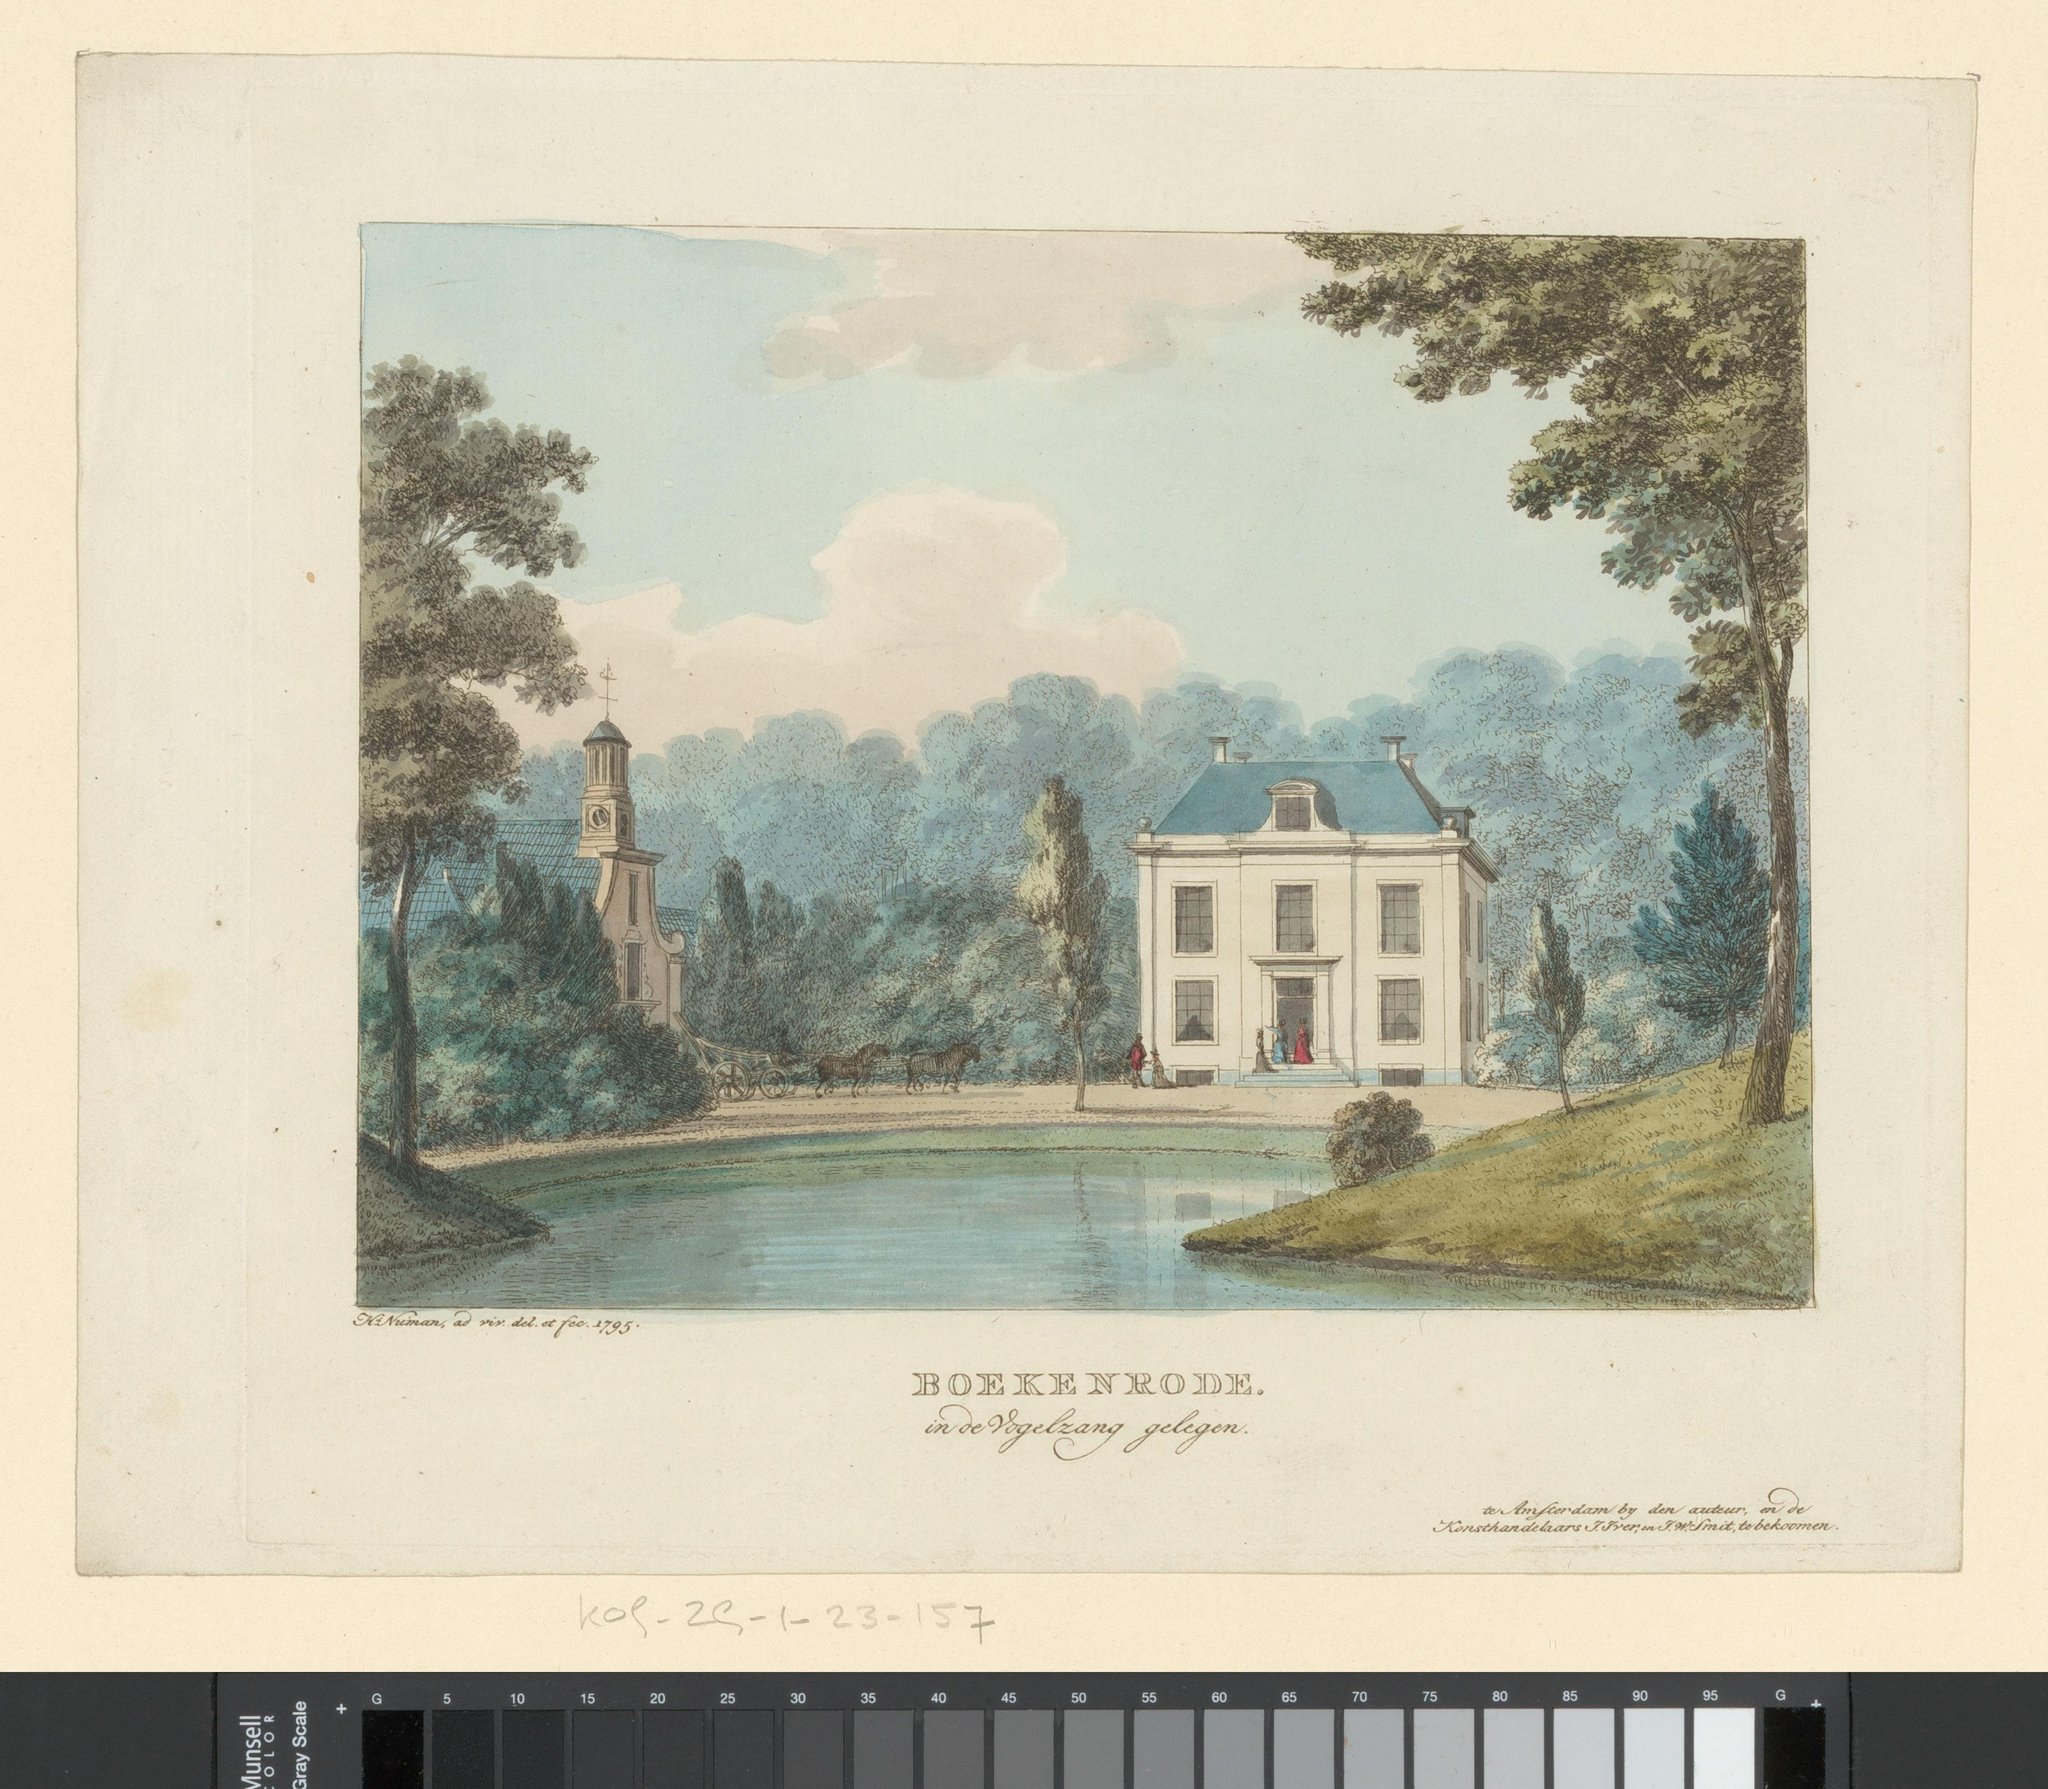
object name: print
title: Gezicht op Buitenplaats Boekenrode te Aerdenhout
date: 1795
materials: paper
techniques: engraving, etching, hand coloring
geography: amsterdam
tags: country-house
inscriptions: stamp, stamp, collector's mark: Lugt 1641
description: Prent gebruikt in: Numan, Hermanus. Vierentwintig printtekeningen met couleuren, verbeeldende Hollandsche buitenplaatzen. Amsterdam: Jan IJver, Jan Willem Smit en Hermanus Numan, 1797.